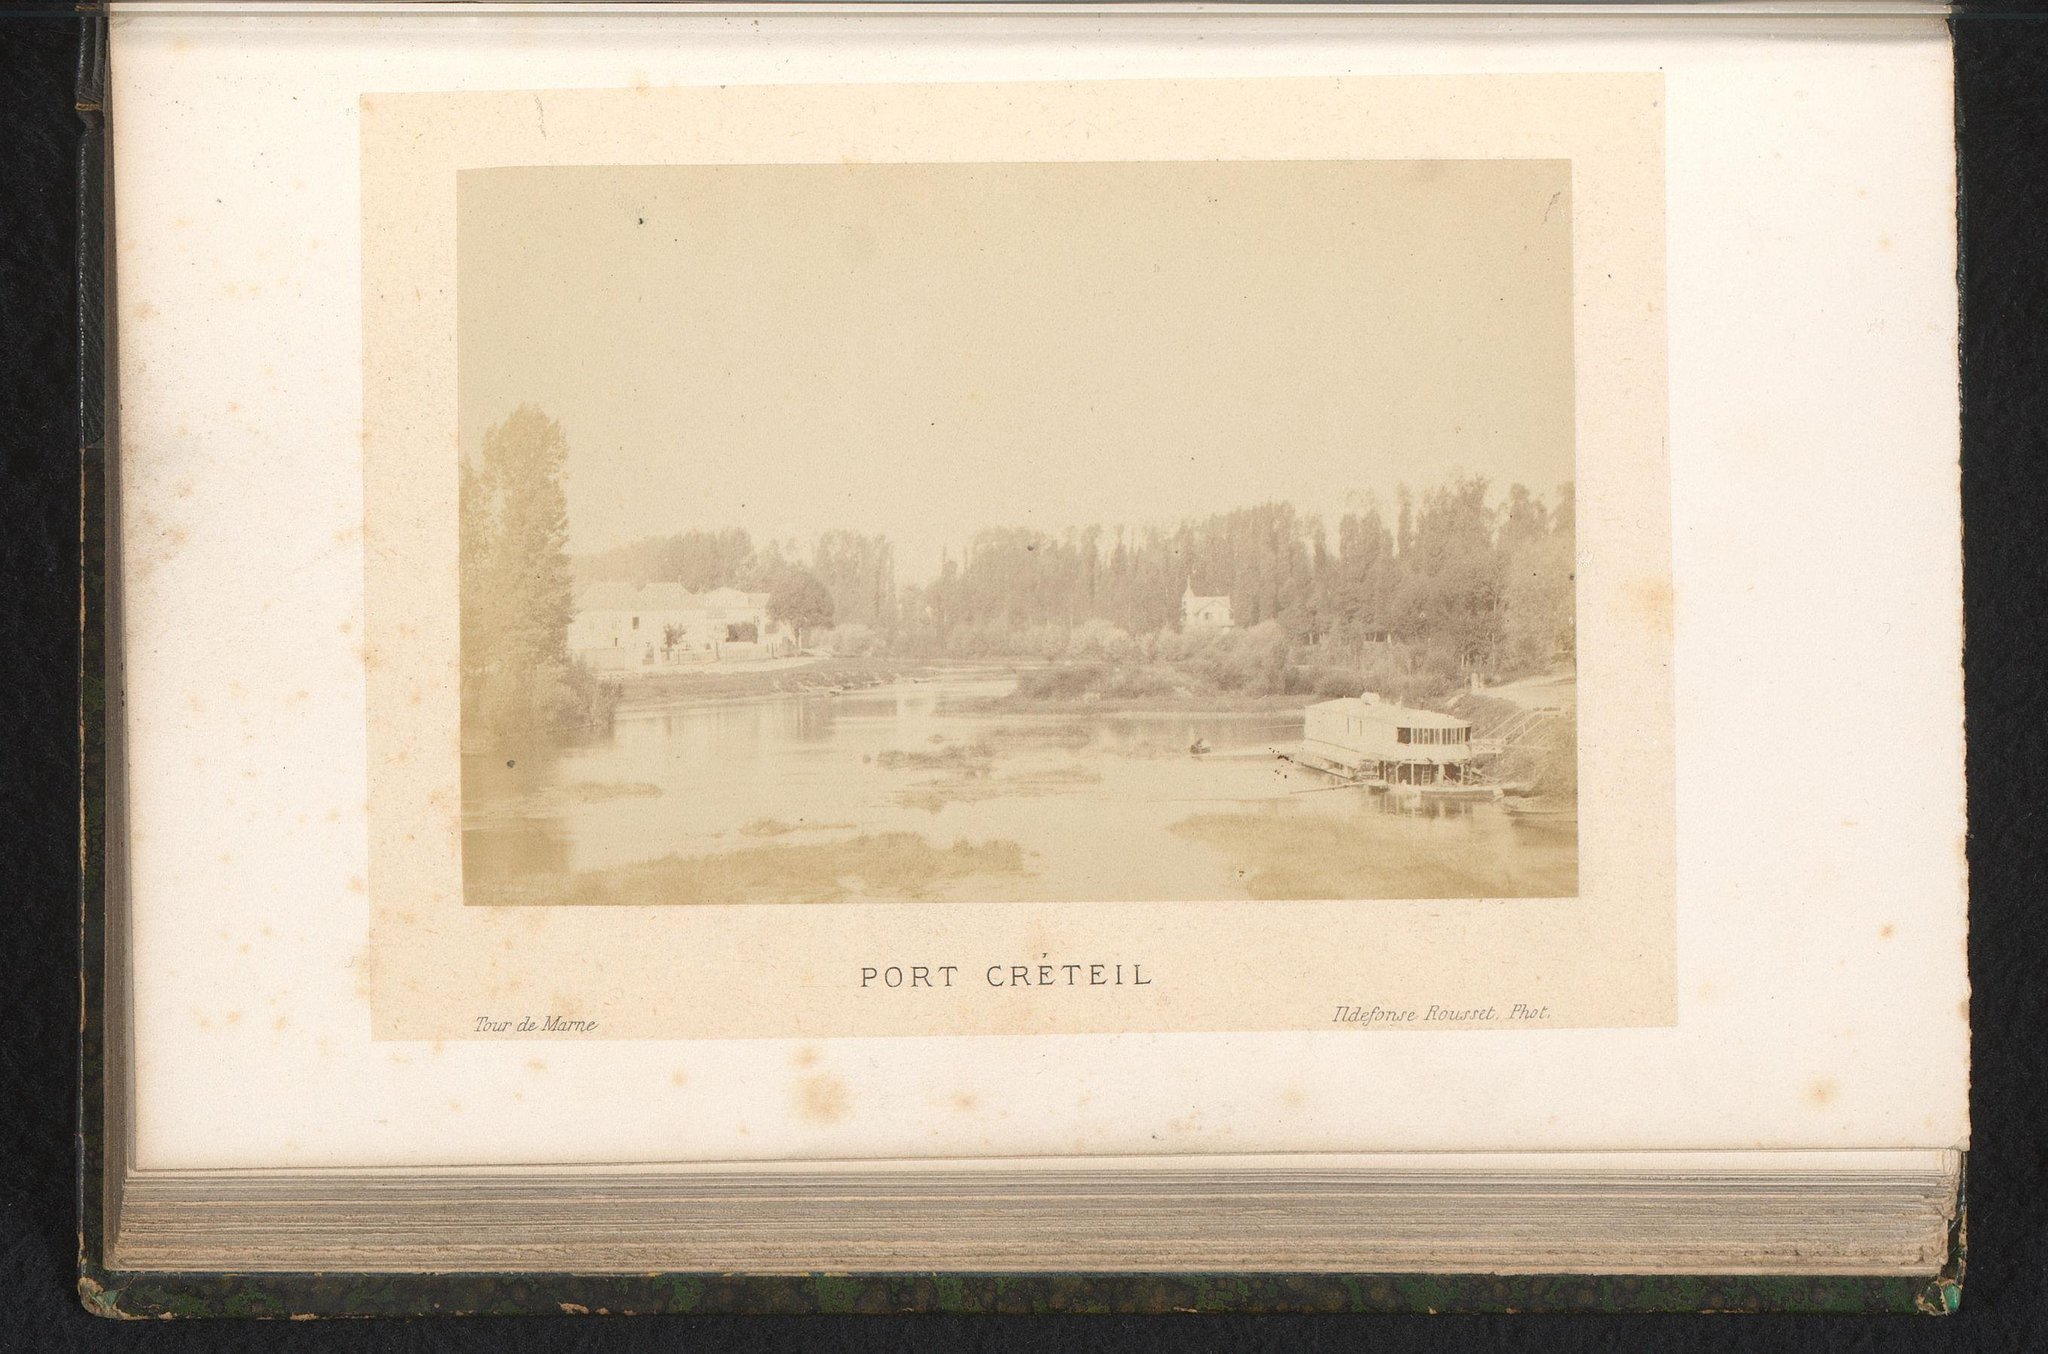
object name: page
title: Port Créteil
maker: ildefonse rousset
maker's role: fotograaf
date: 1860-1865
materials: paper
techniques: albumen print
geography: créteil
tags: river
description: Foto op ongenummerde pagina tegenover pagina 109.